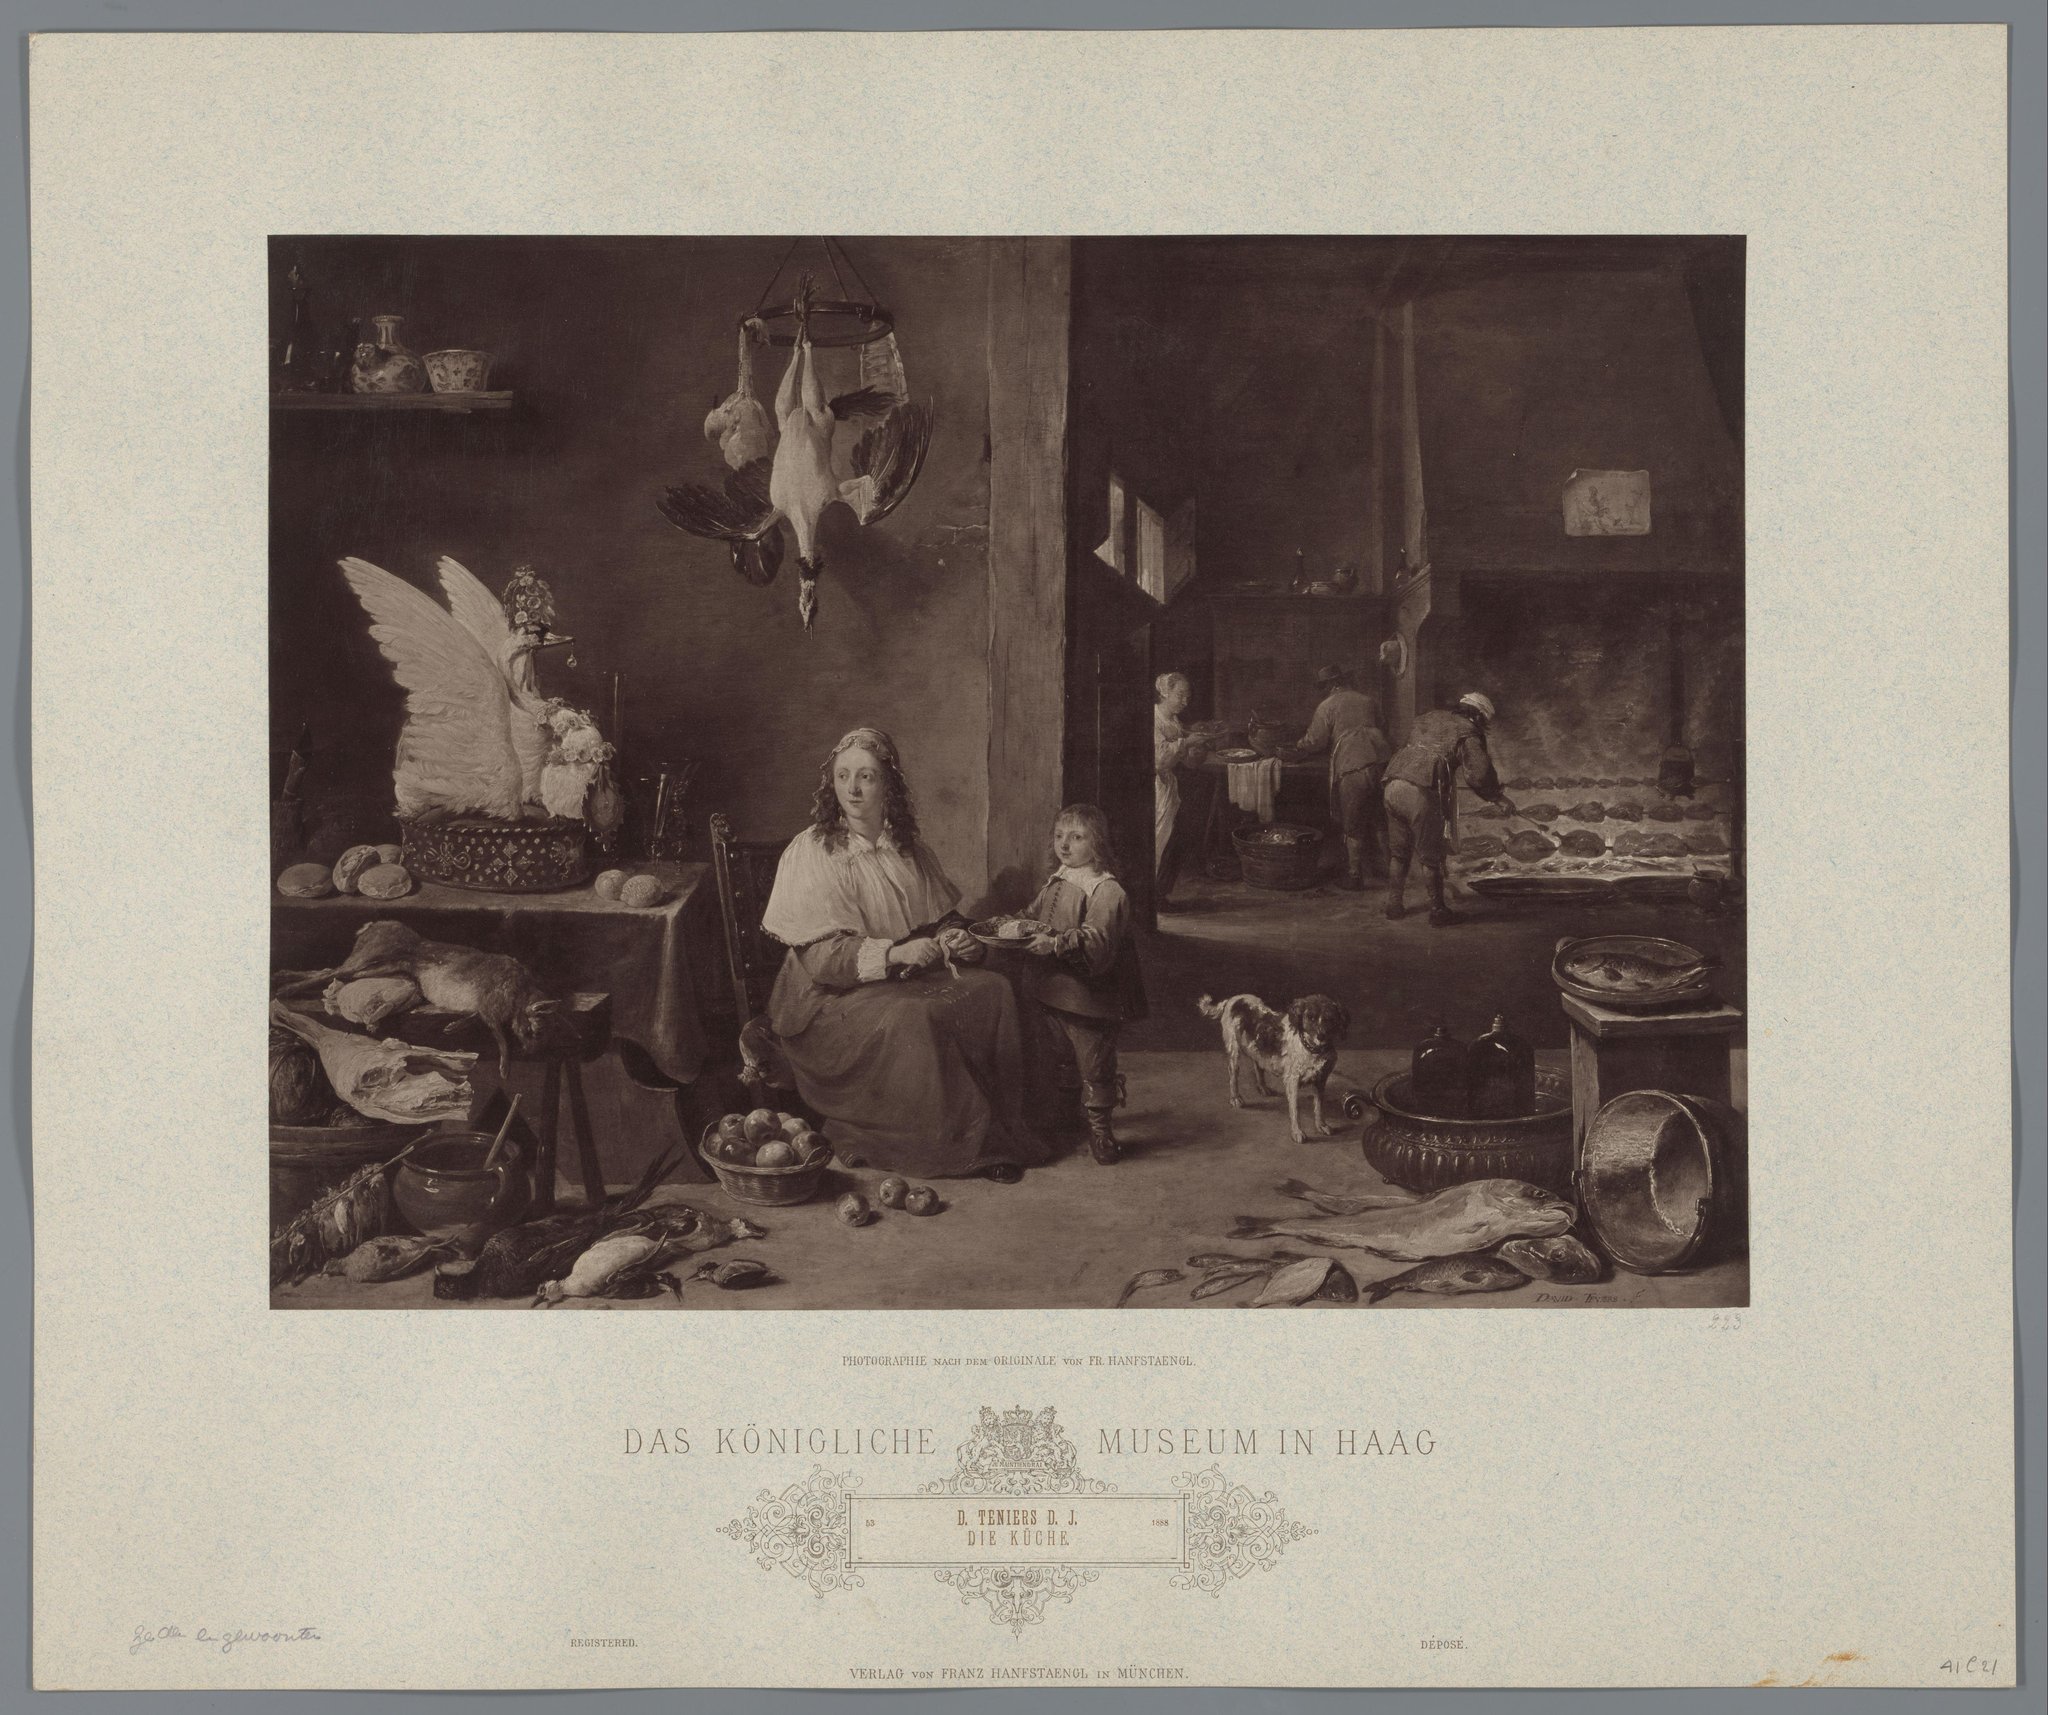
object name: photograph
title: Das Königliche Museum in Haag / 53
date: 1888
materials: cardboard, paper, photographic support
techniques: collodion silver print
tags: picture, painting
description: Das Königliche Museum in Haag / D. Teniers D.J. / Die Küche.